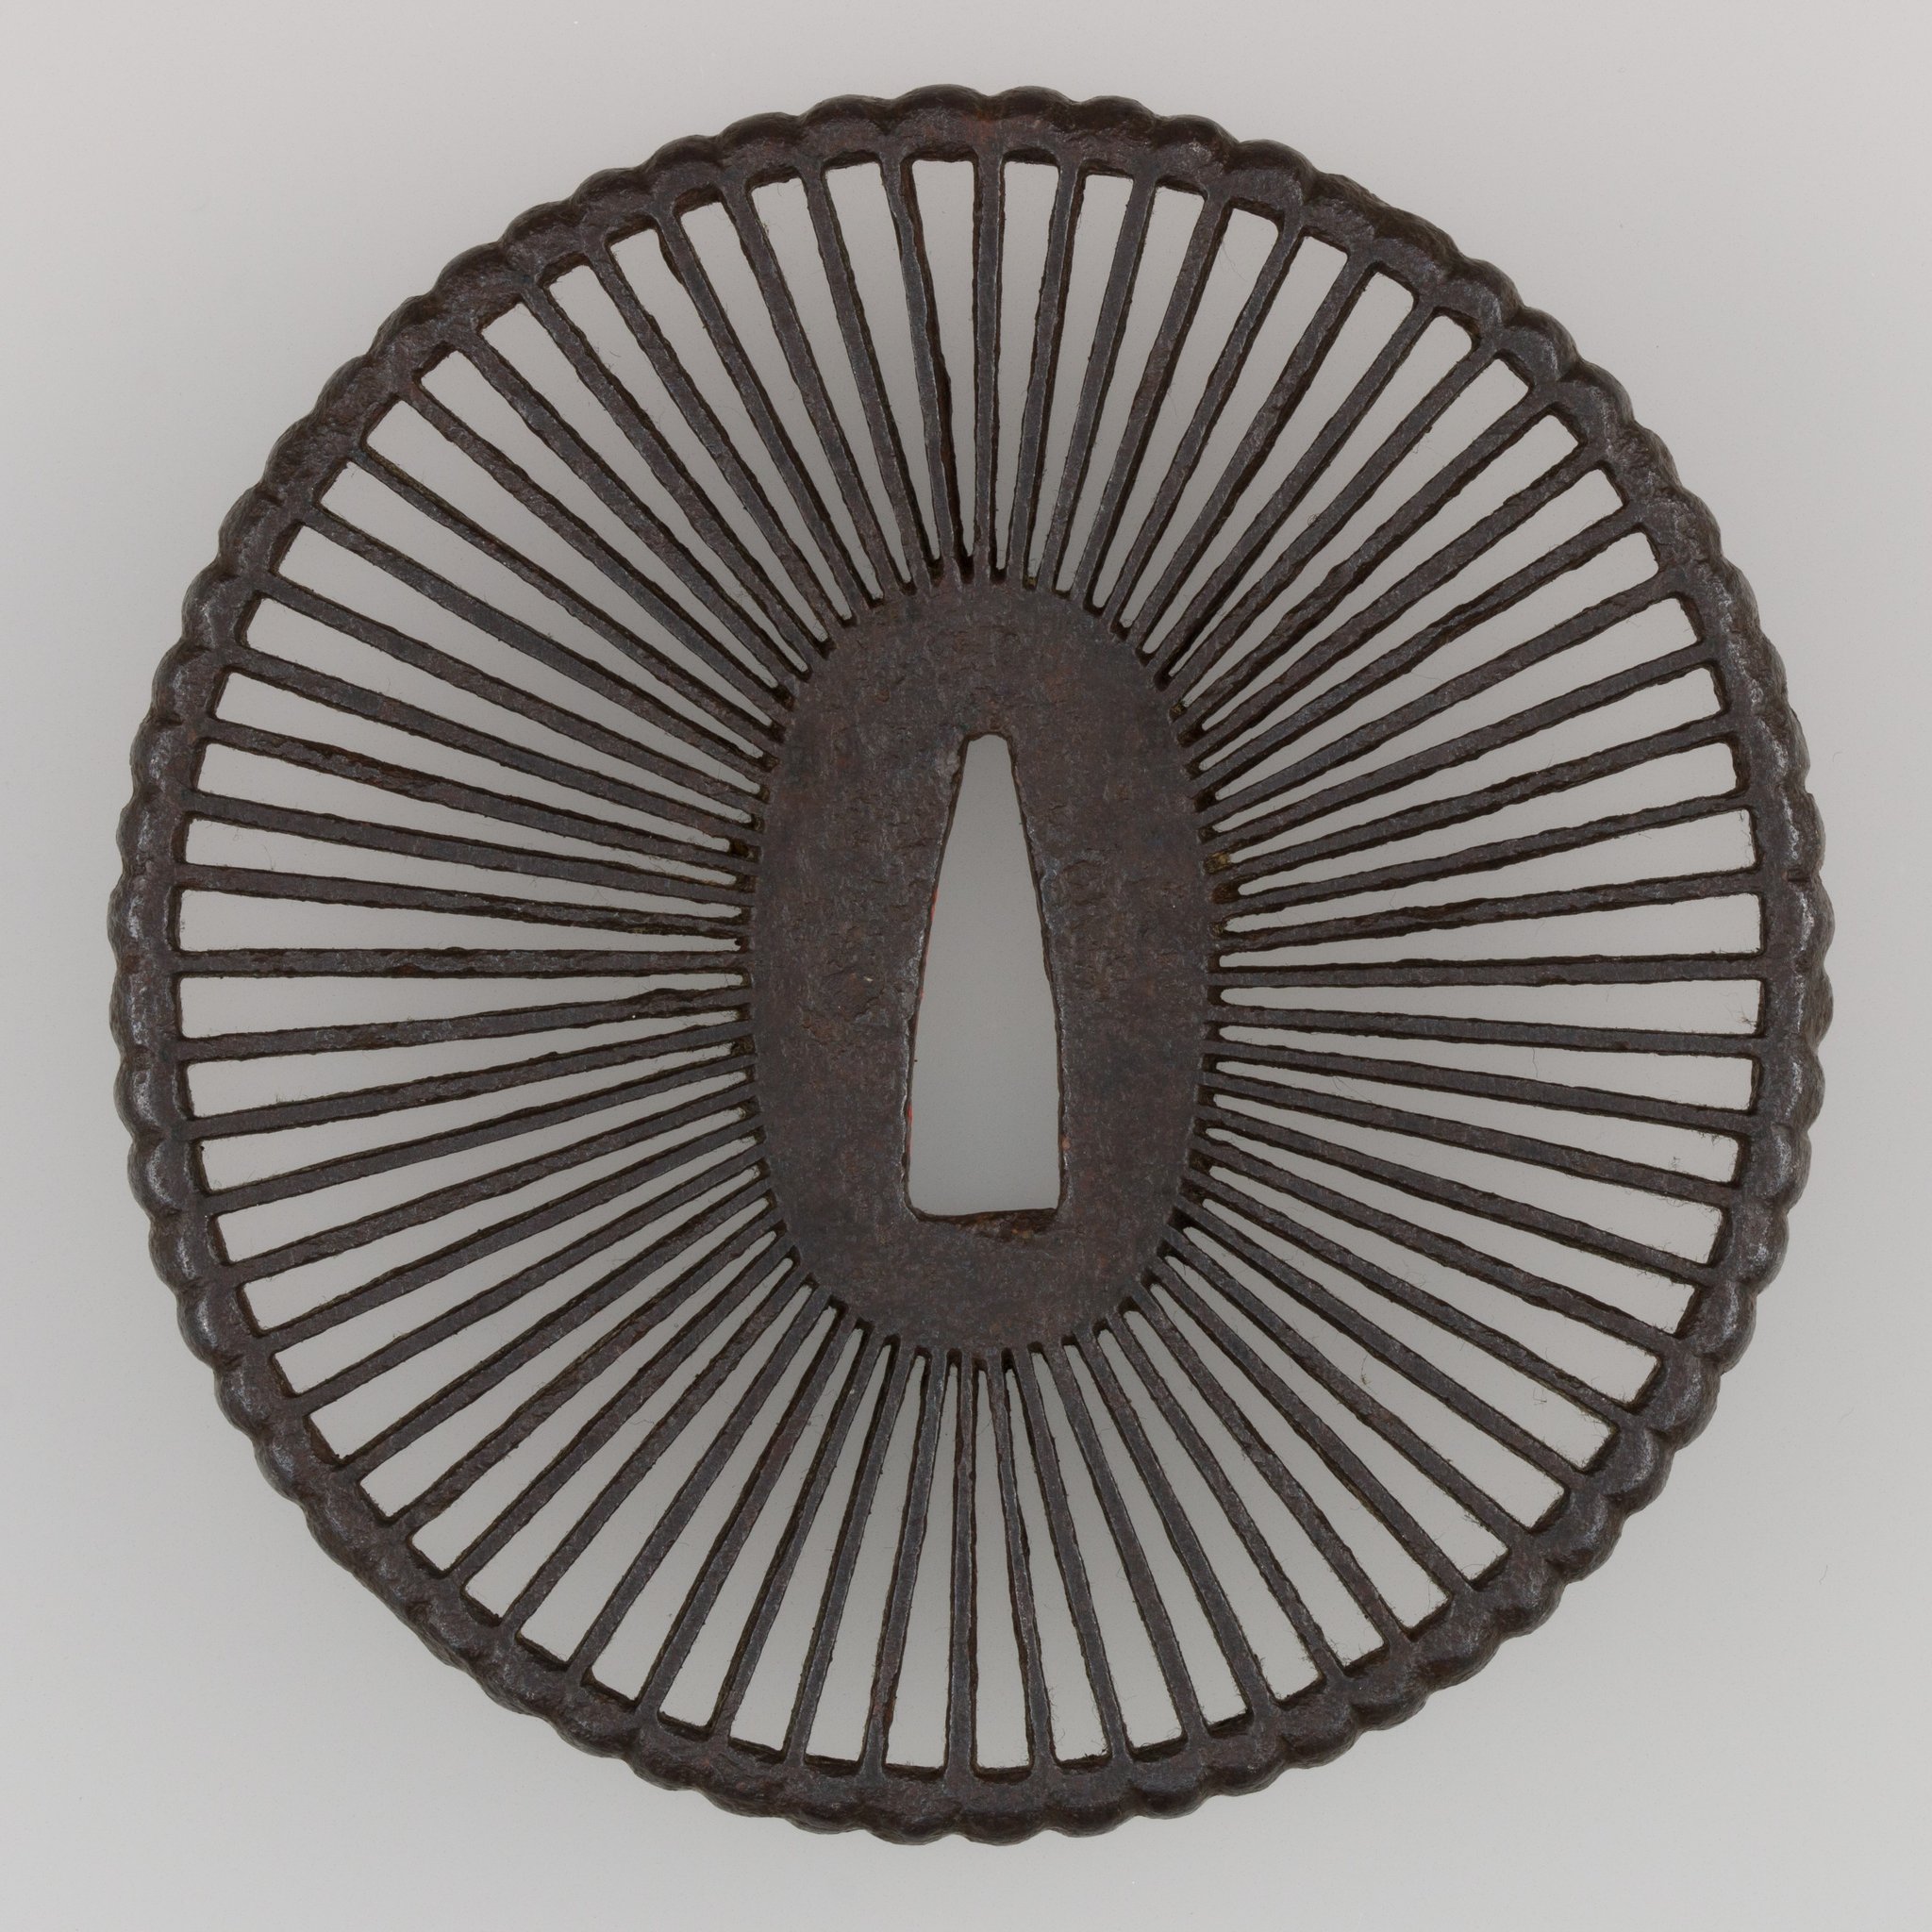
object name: sword guard tsuba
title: Sword Guard (Tsuba)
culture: japanese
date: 1501-1600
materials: copper, iron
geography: japan